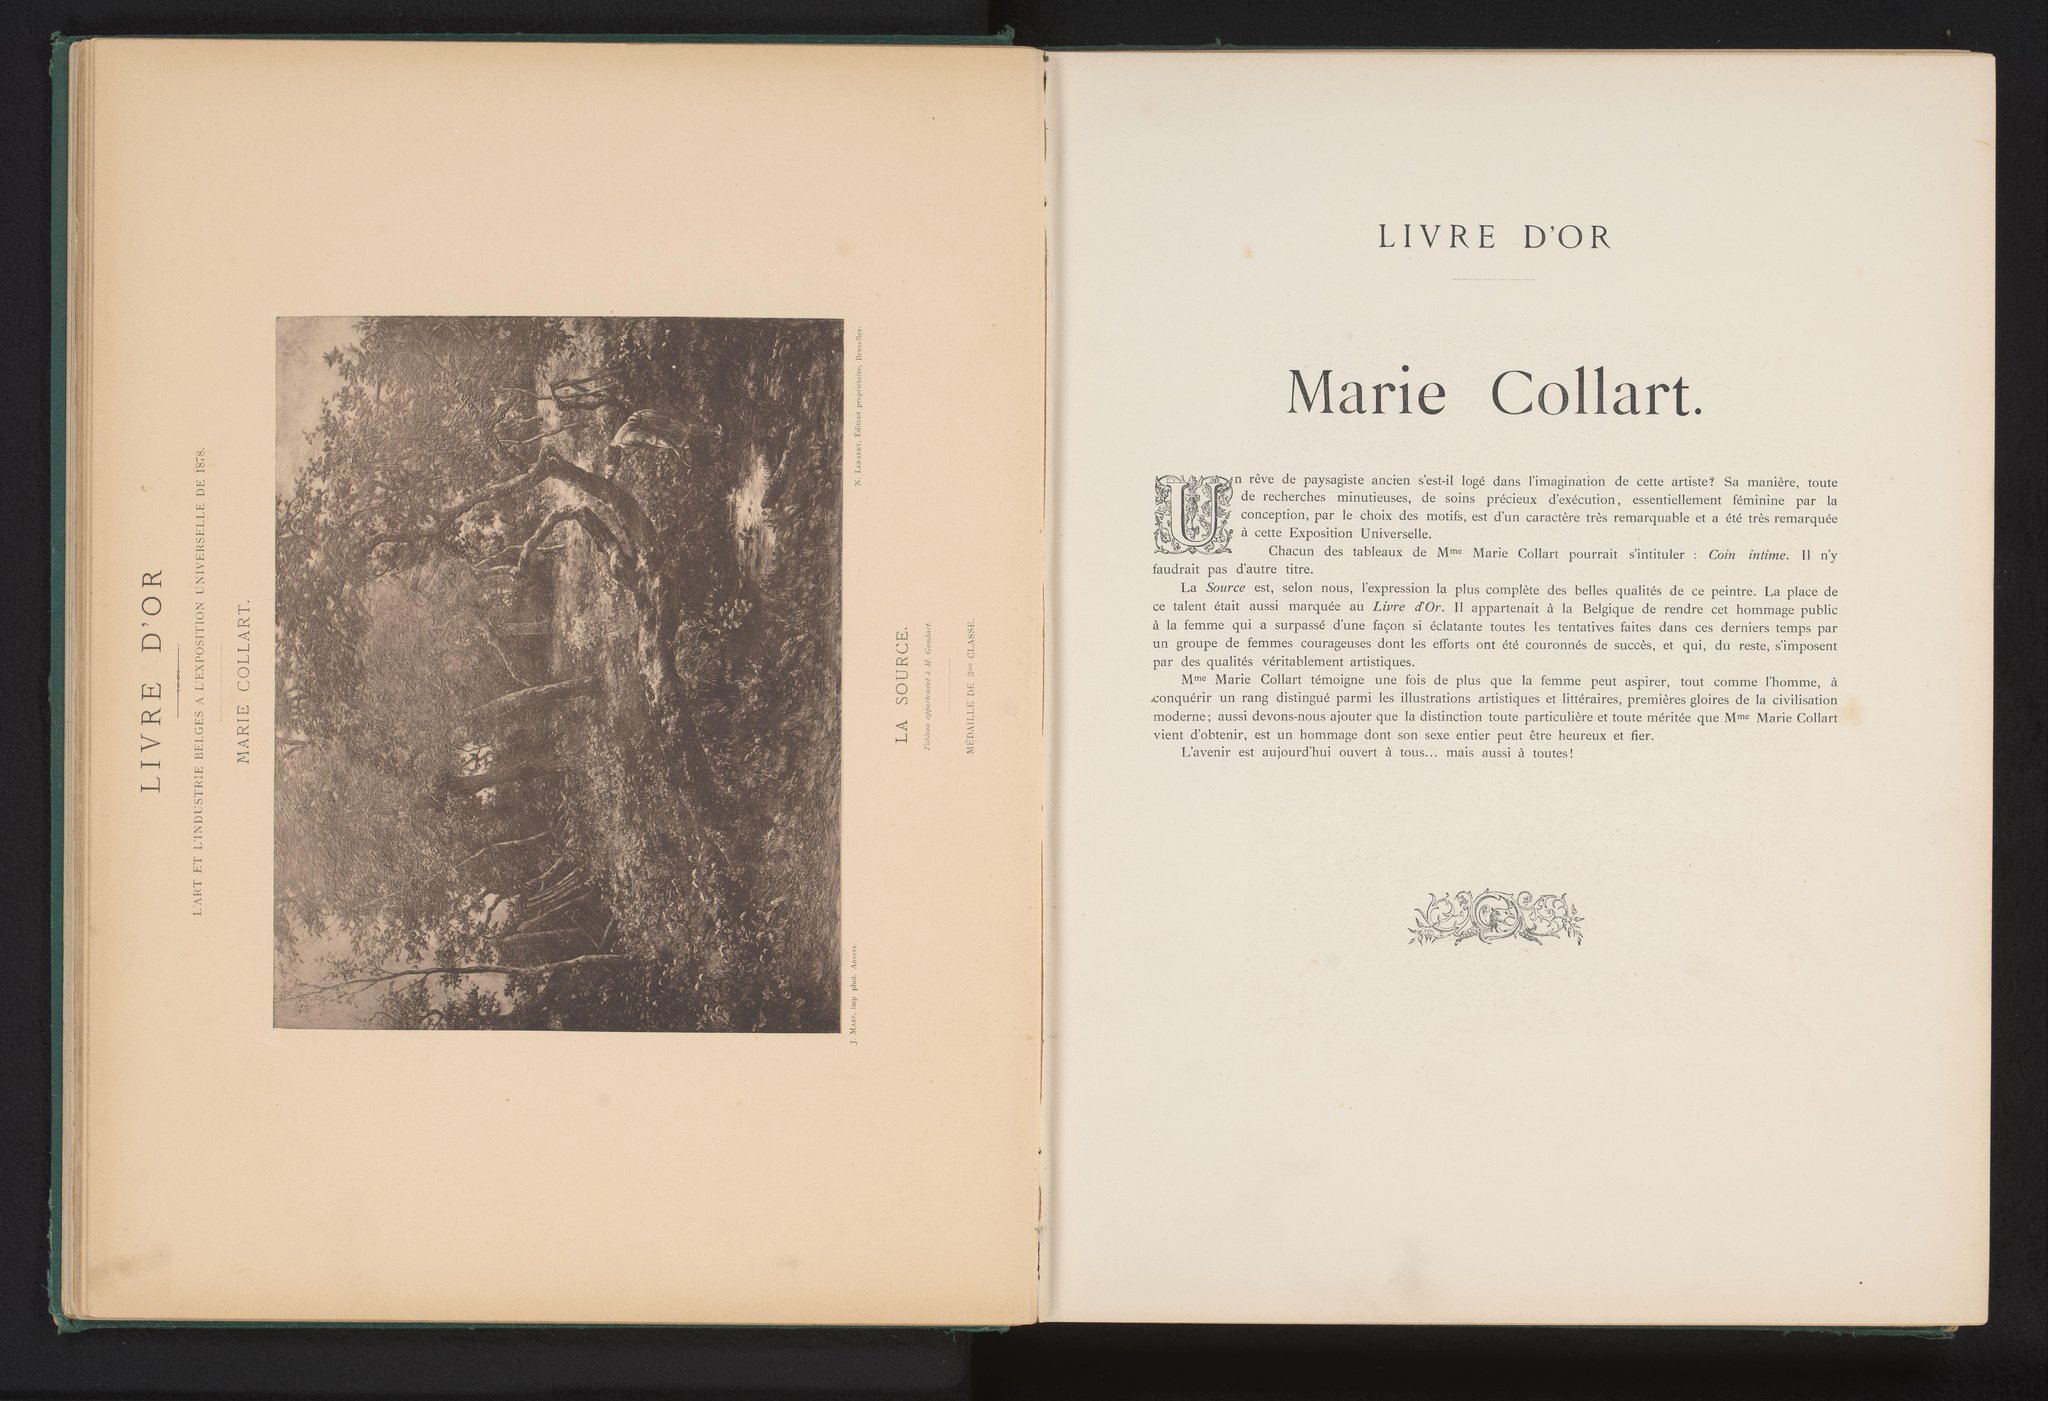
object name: reproduction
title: Reproductie van een schilderij van een vrouw in het bos bij een waterpoel door Marie Collart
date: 1874-1879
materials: paper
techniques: photograph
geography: antwerp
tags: pool, puddle (+ landscape with figures, staffage), forest, wood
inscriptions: inscription: ‘Livre d'or/ L'art et l'industrie Belges a l'exposition universelle de 1878.’, inscription: ‘Tableau appartenant à M. Gambart.’